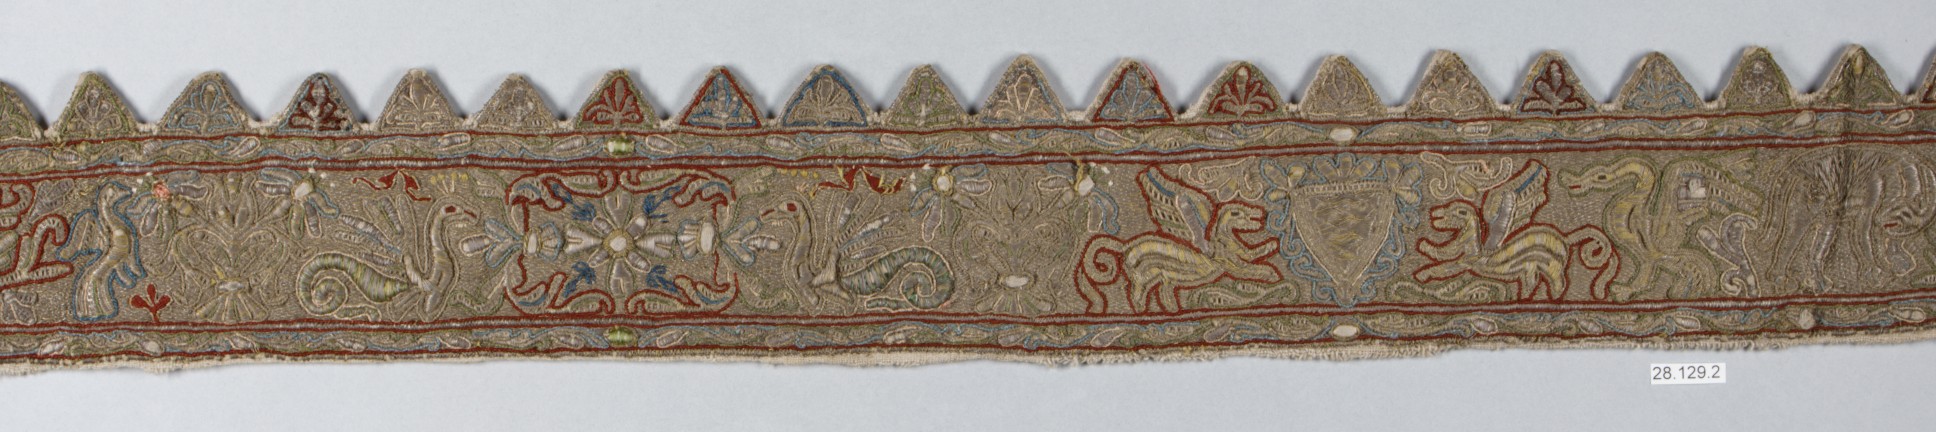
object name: galloon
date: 1601-1700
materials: linen, metal thread, silk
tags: mythical creatures